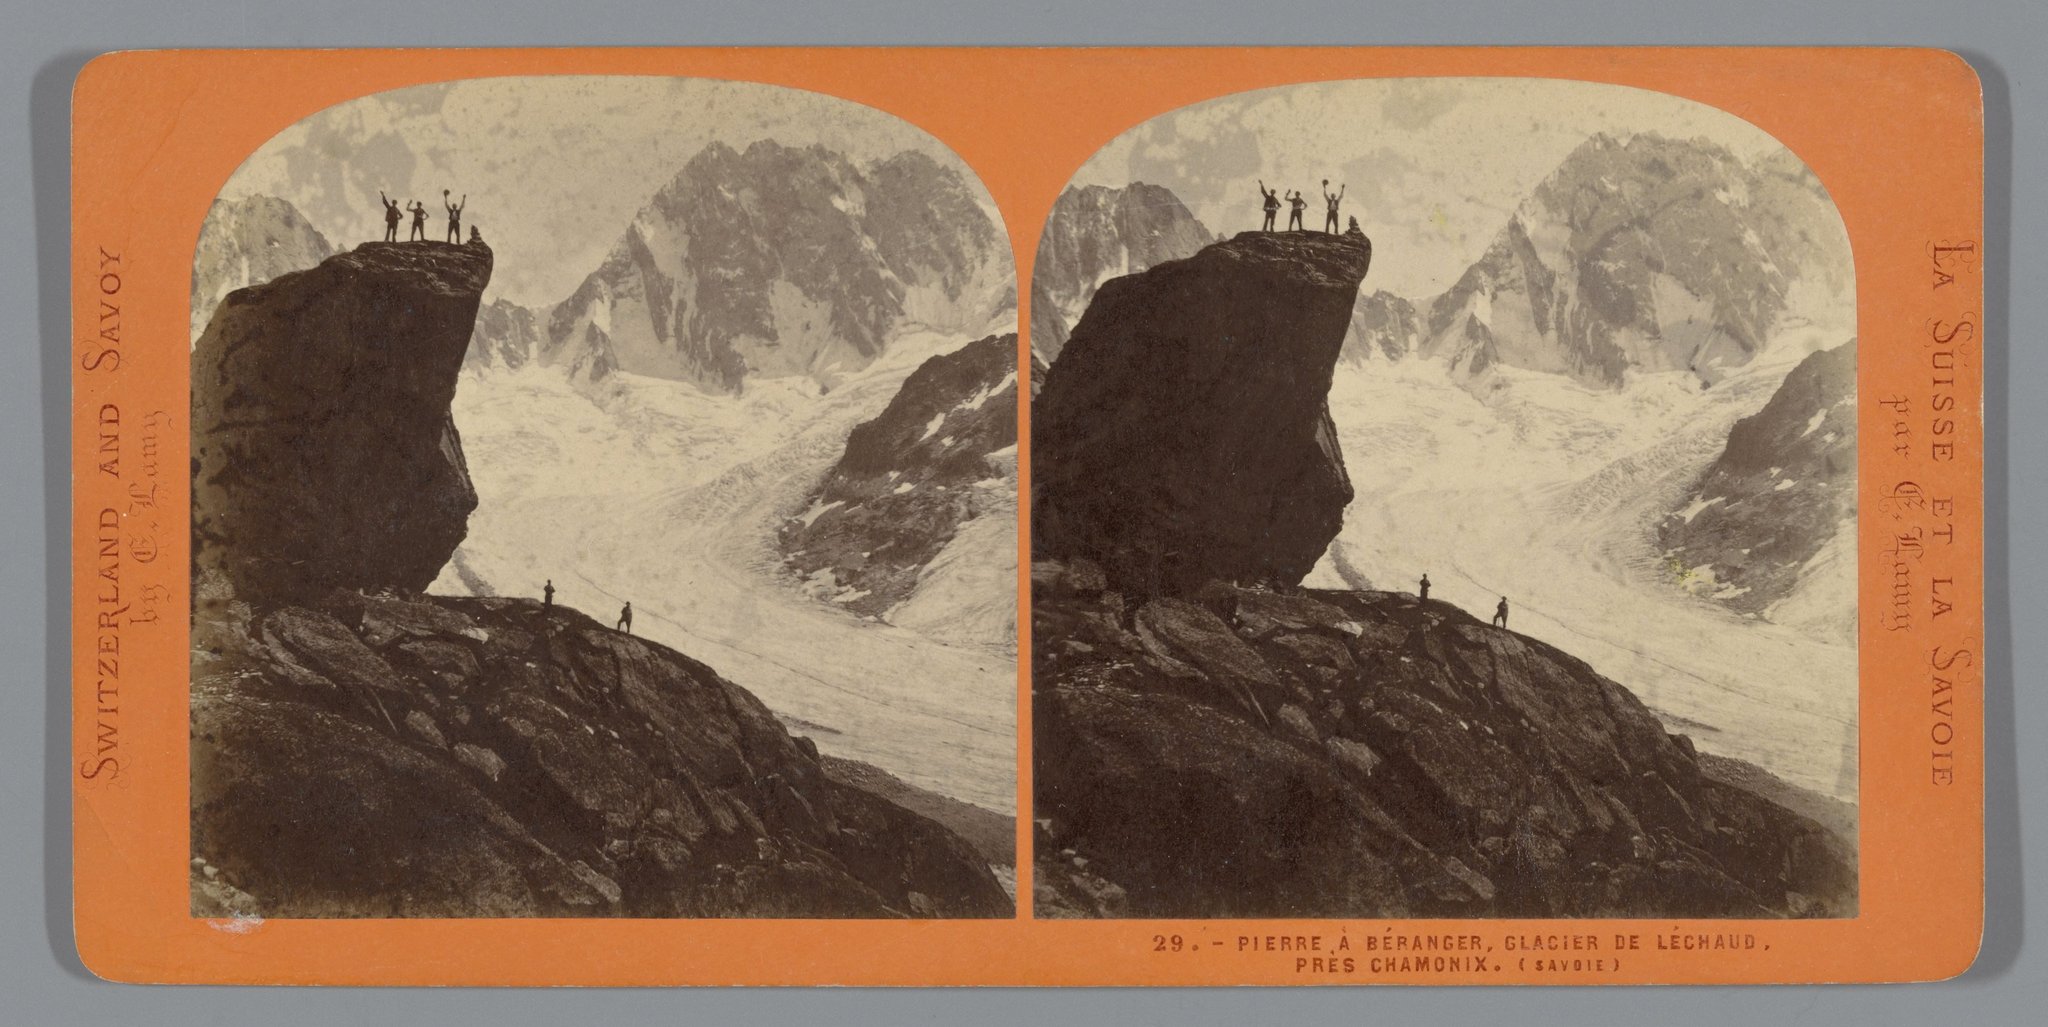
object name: stereograph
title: Pierre à Béranger, Glacier de Léchaud, près Chamonix. (Savoie)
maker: ernest eléonor pierre lamy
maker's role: publisher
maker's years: 1828-1900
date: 1860-1880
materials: cardboard, photographic support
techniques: albumen print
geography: haute-savoie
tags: glacier, rock-formations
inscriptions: number: ‘29.’